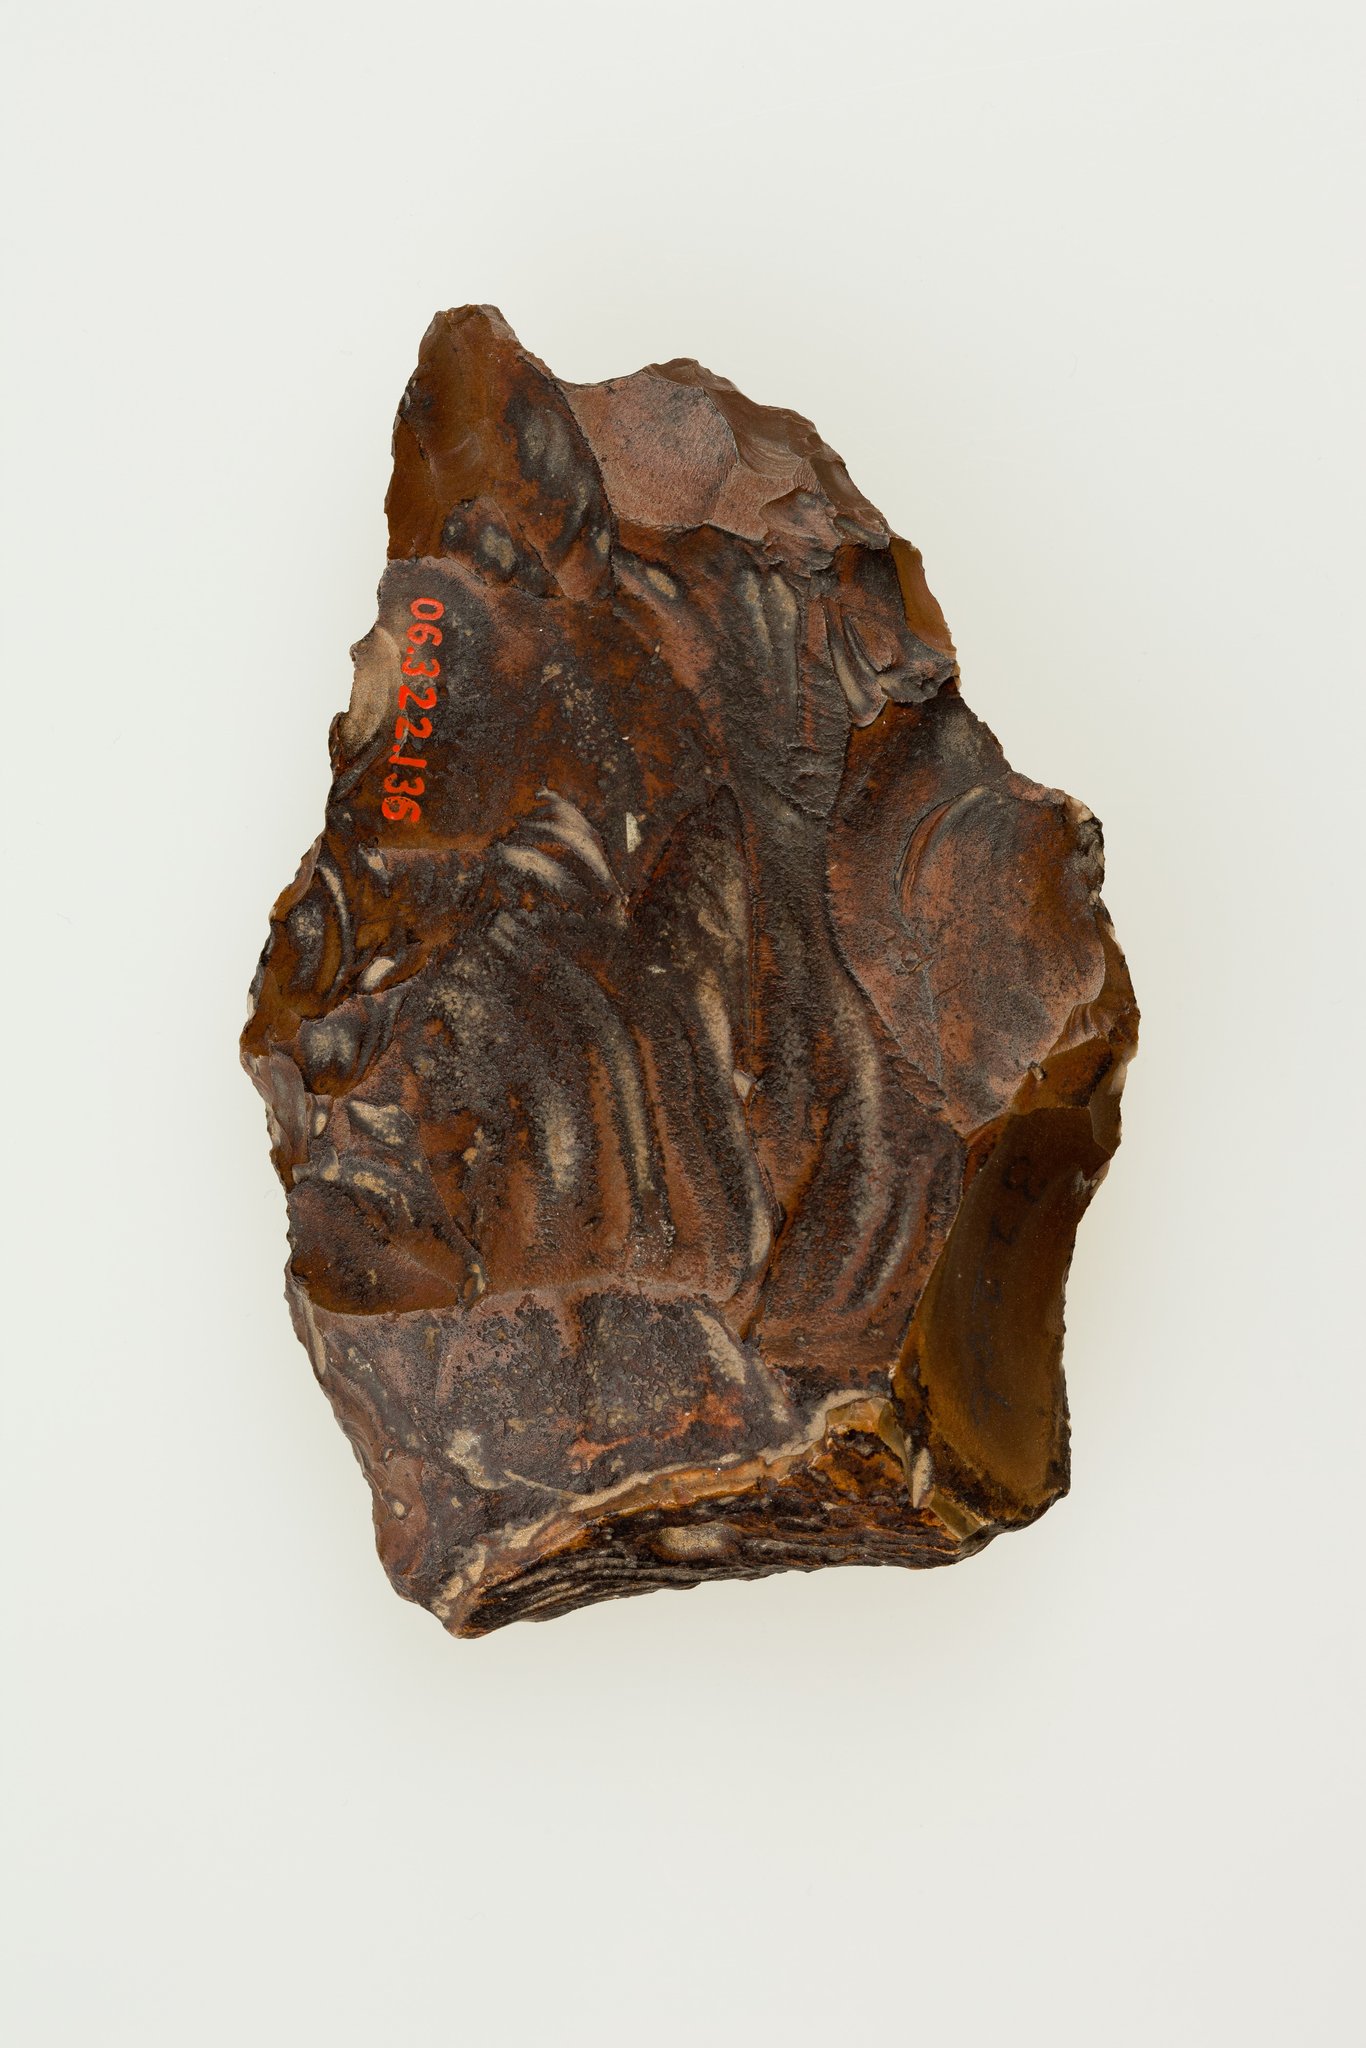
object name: tool, biface, hand ax, sub cordiform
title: Biface, commonly referred to as a hand ax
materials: stone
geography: egypt